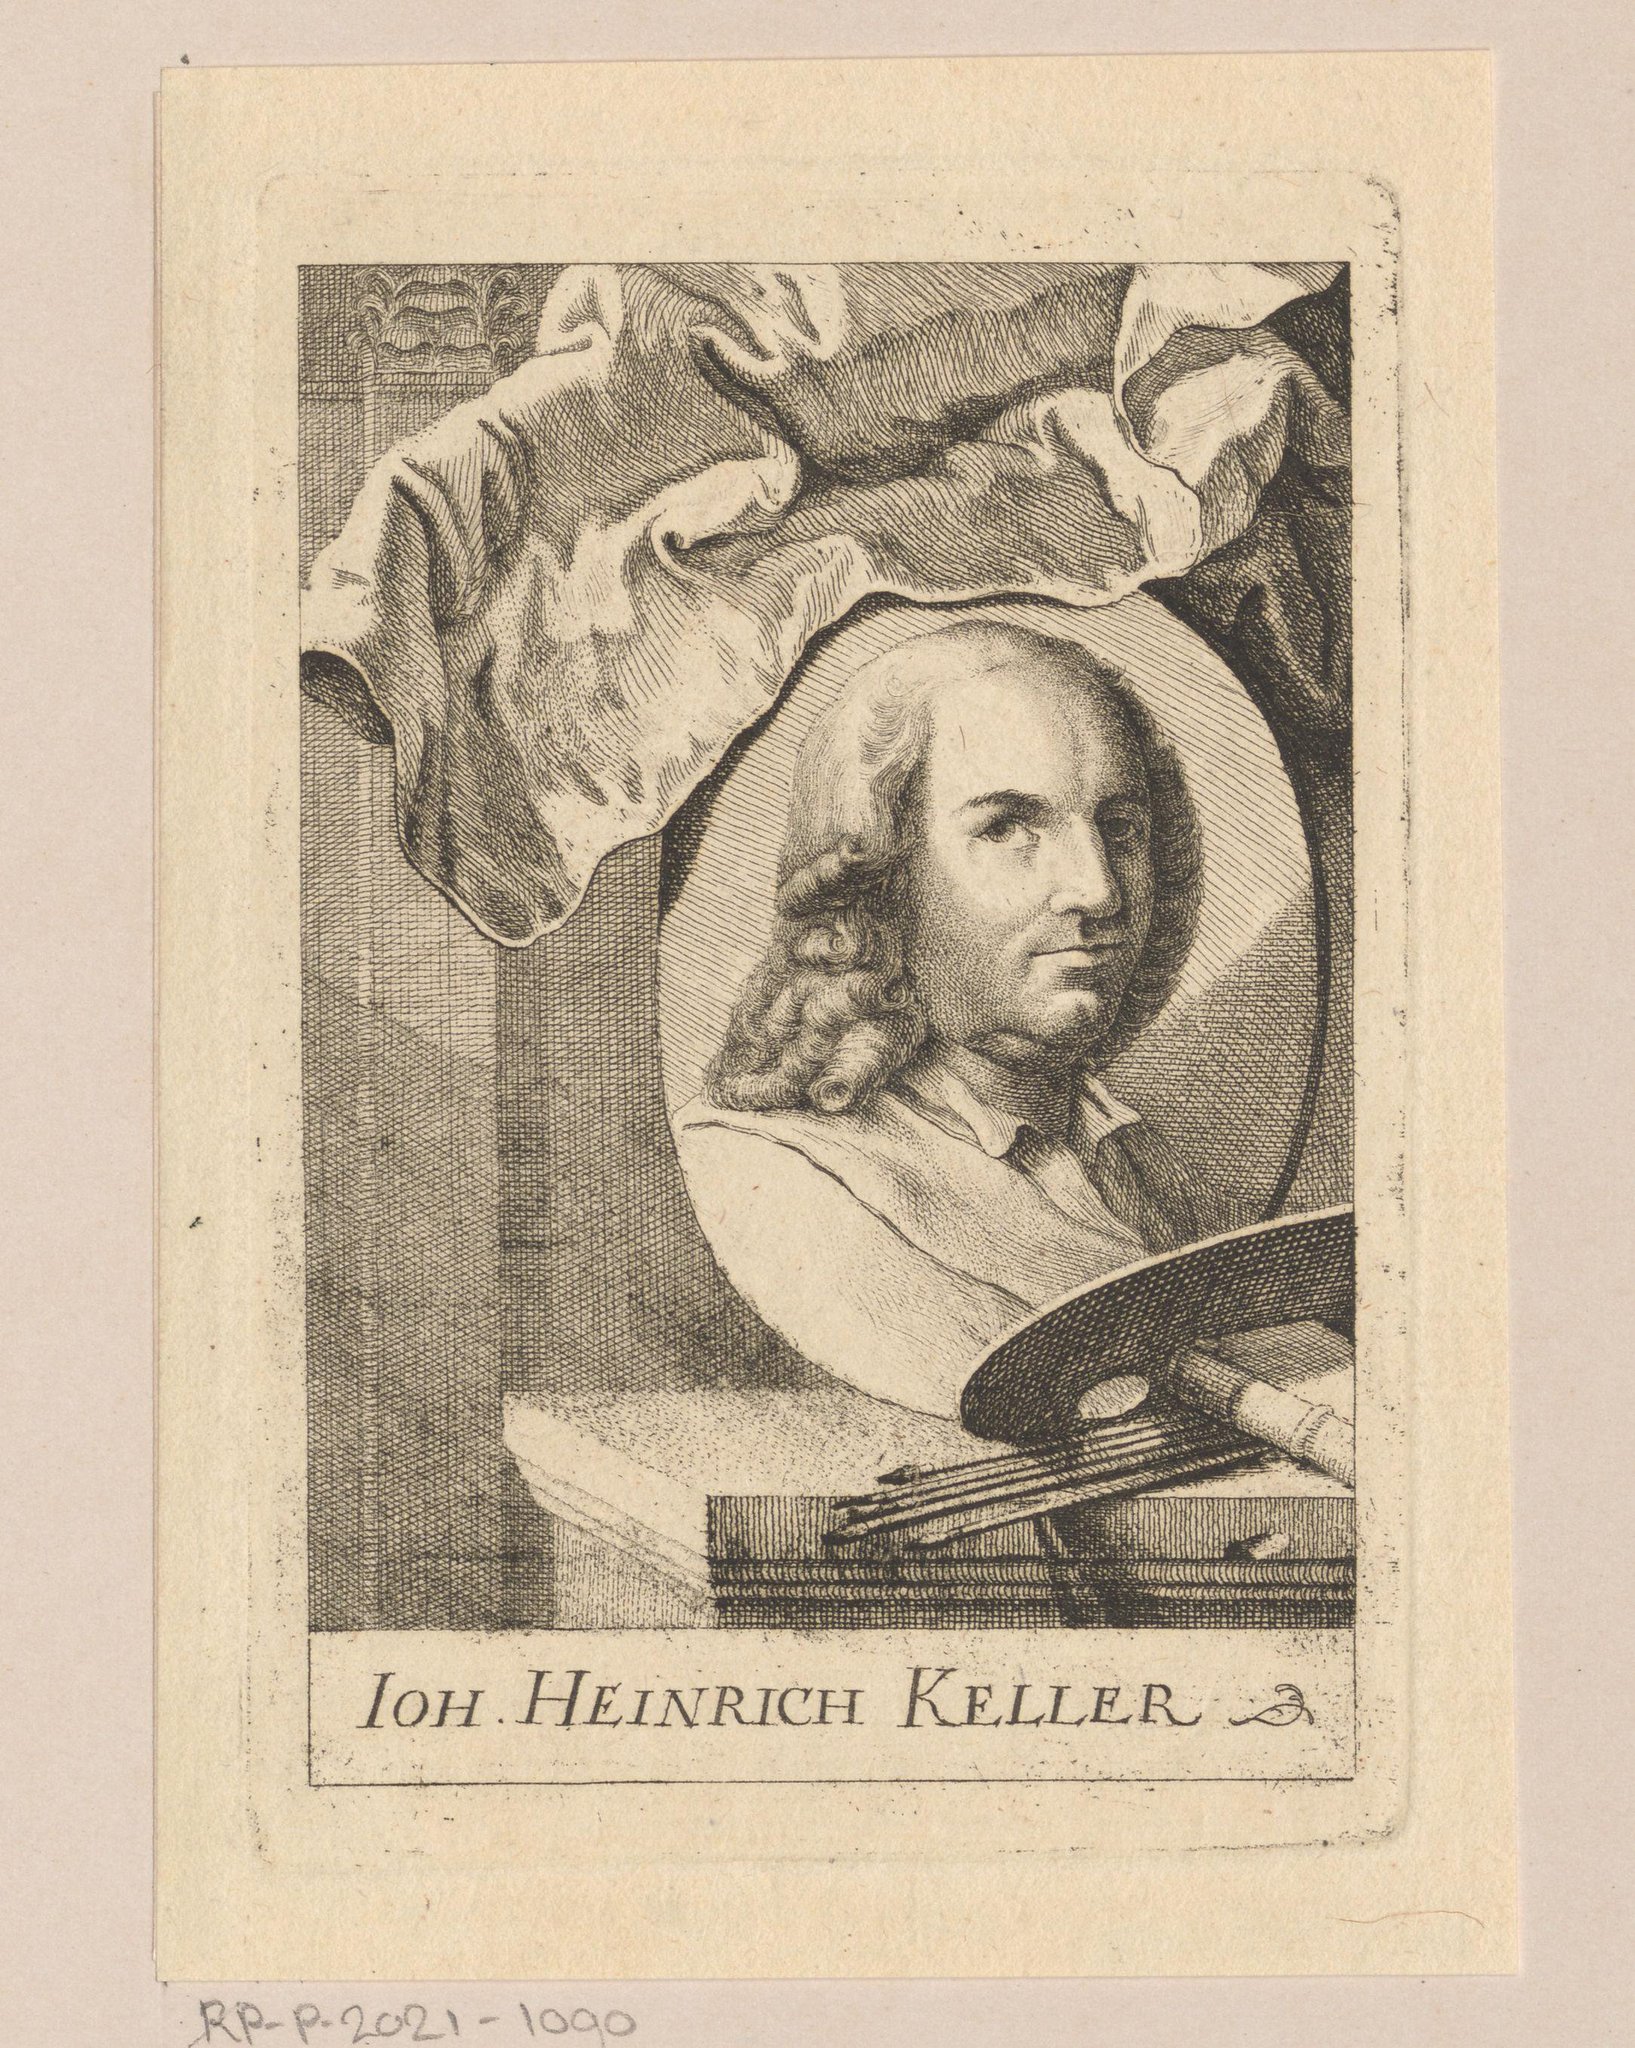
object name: print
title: Portret van Johann Heinrich Keller II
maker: Anonymous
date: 1730-1799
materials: paper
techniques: etching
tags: the hague, painter, draughtsman, johann heinrich keller (ii), historical persons, portrait, self-portrait of painter, painting (including book-illumination, miniature-painting)